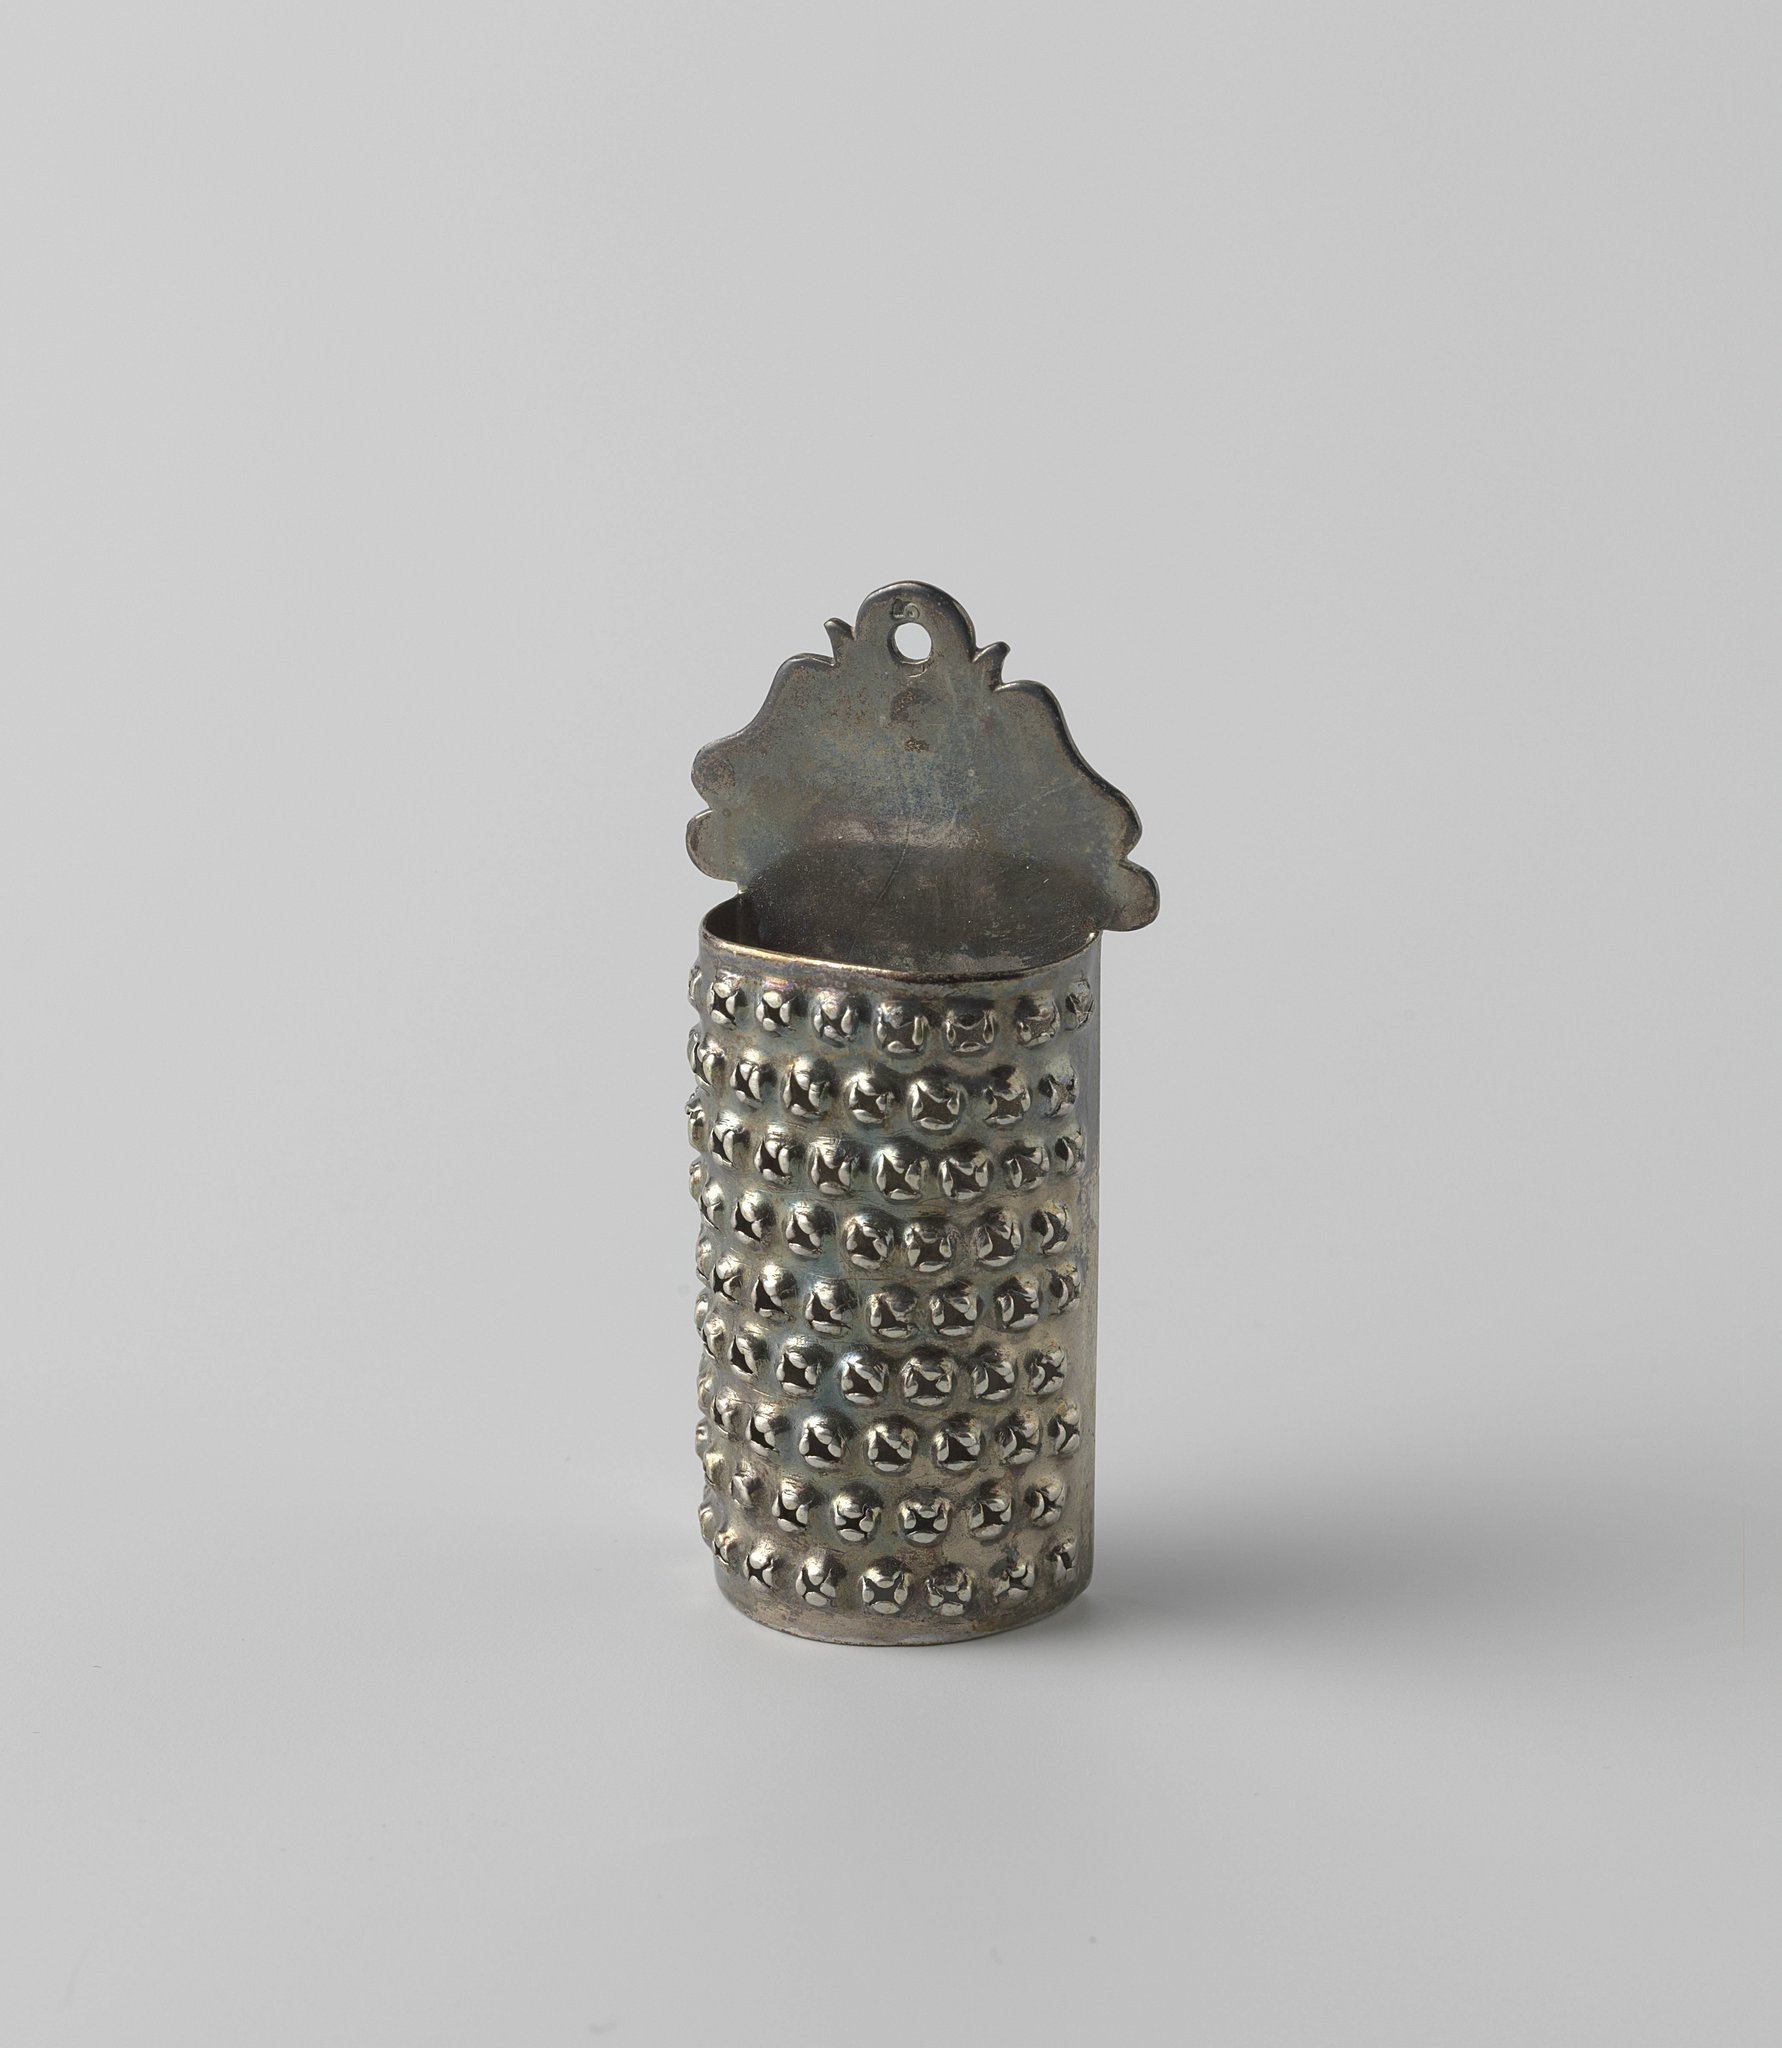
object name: miniature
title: Rasp van zilver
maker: Anonymous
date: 1400-1950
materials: silver